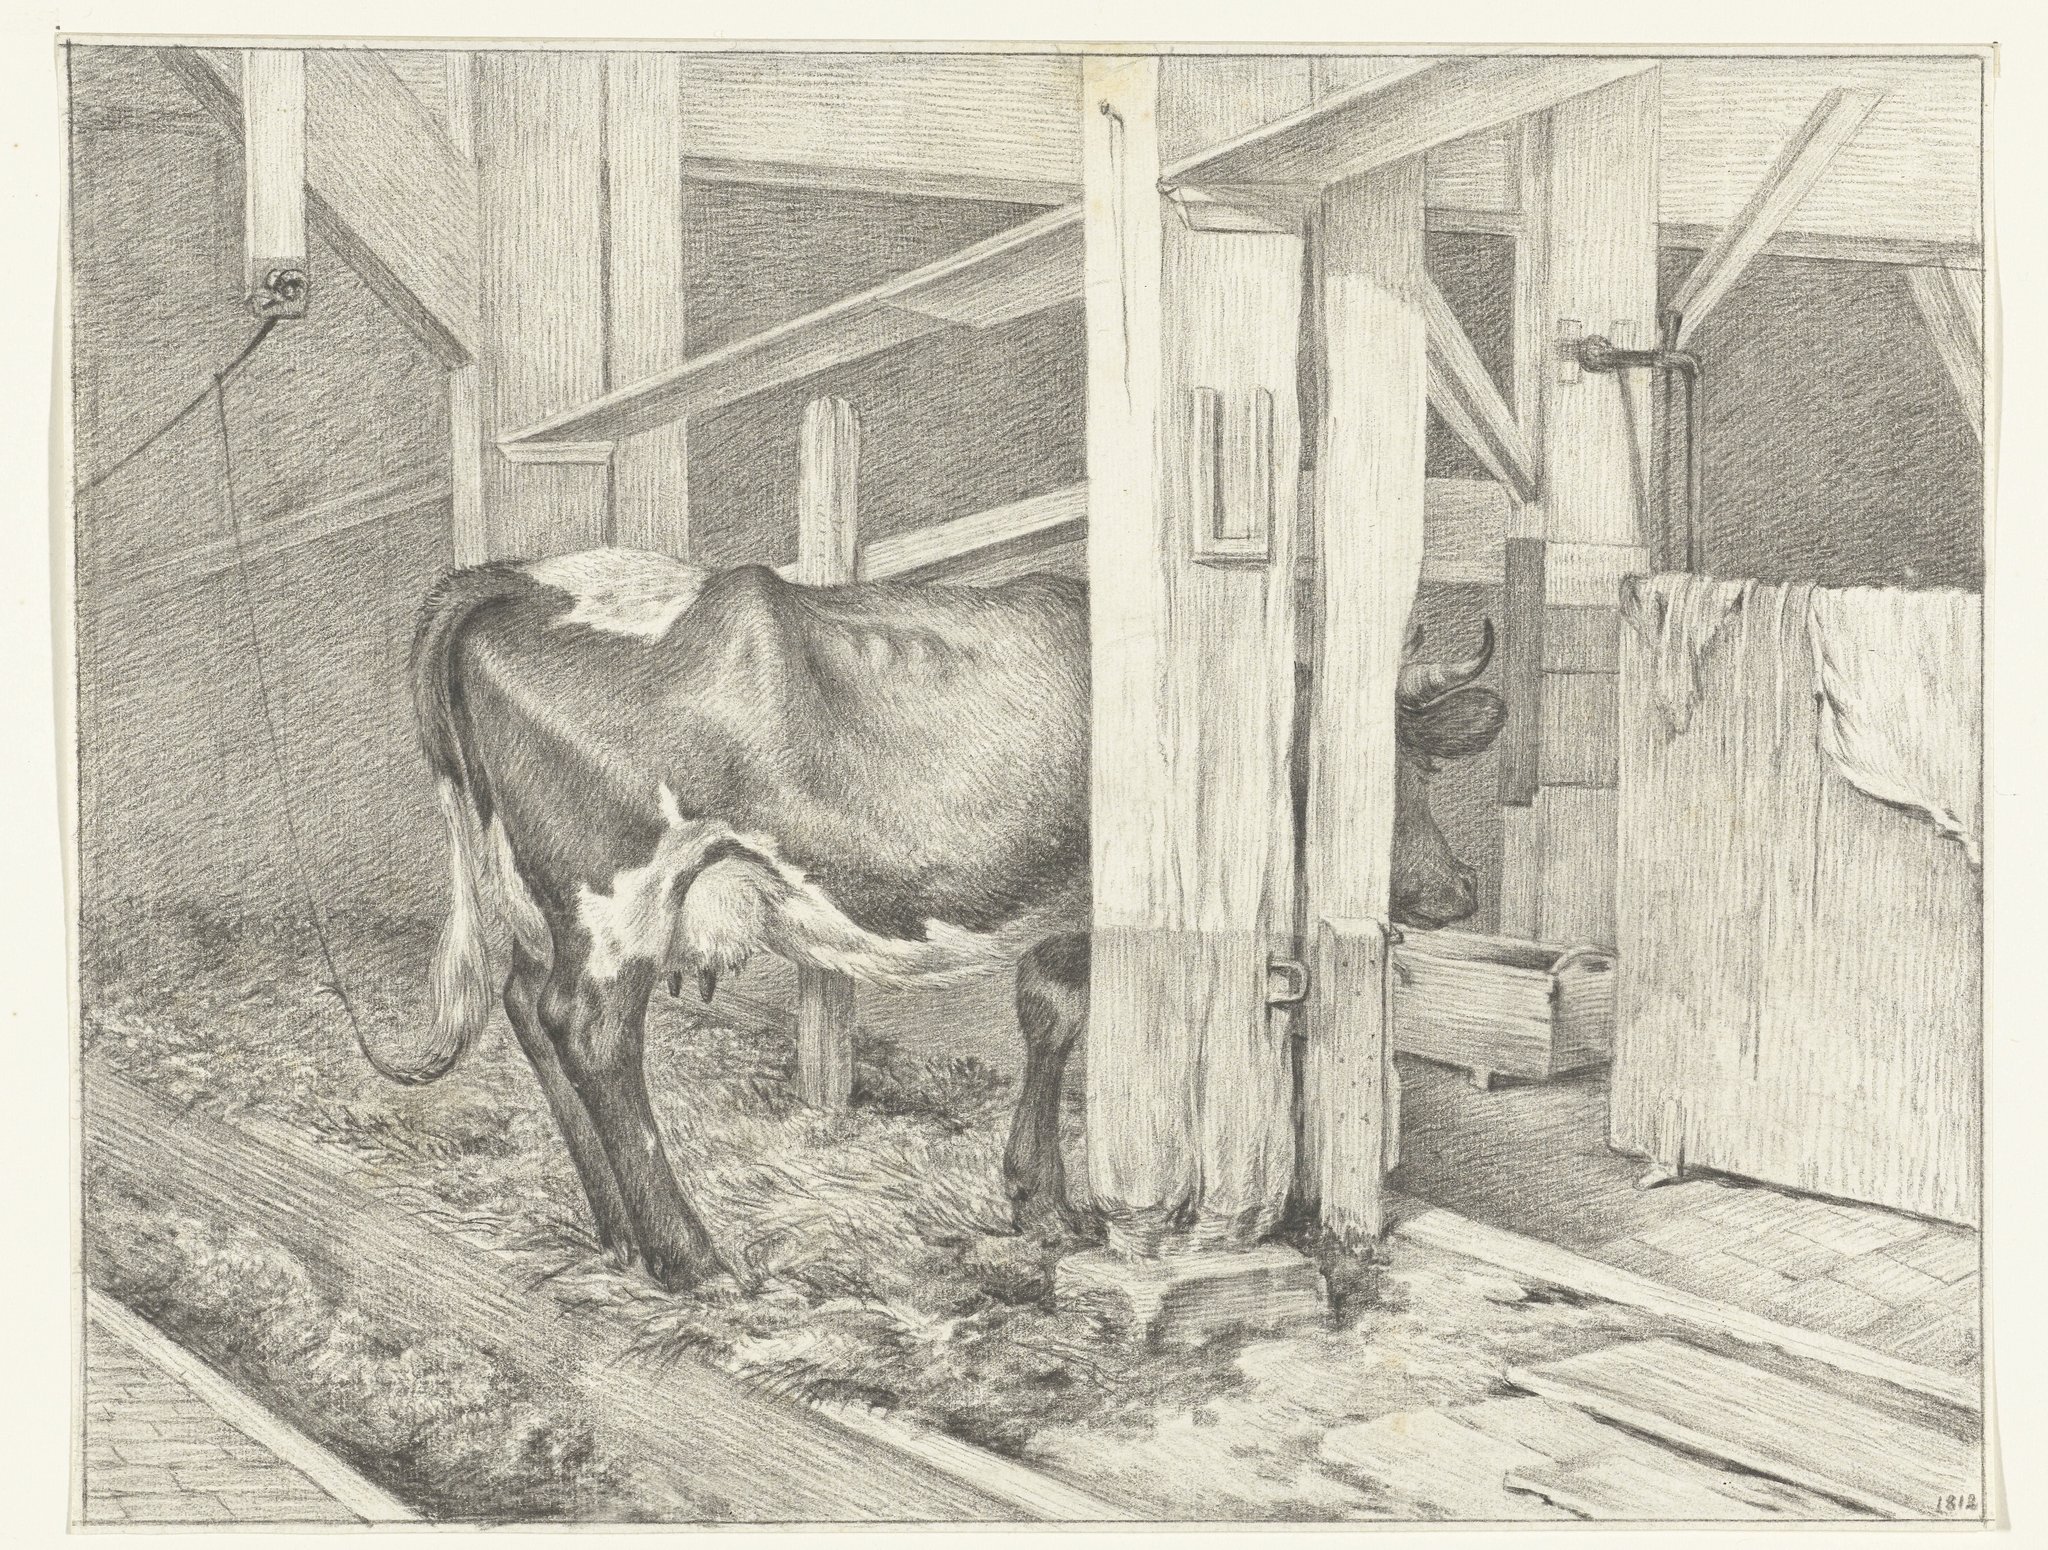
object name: drawing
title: Staande koe in een stal, naar rechts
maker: jean bernard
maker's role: draughtsman, print maker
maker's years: 1765-1833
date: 1812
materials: chalk, paper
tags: cow, calf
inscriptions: date: ‘1812’